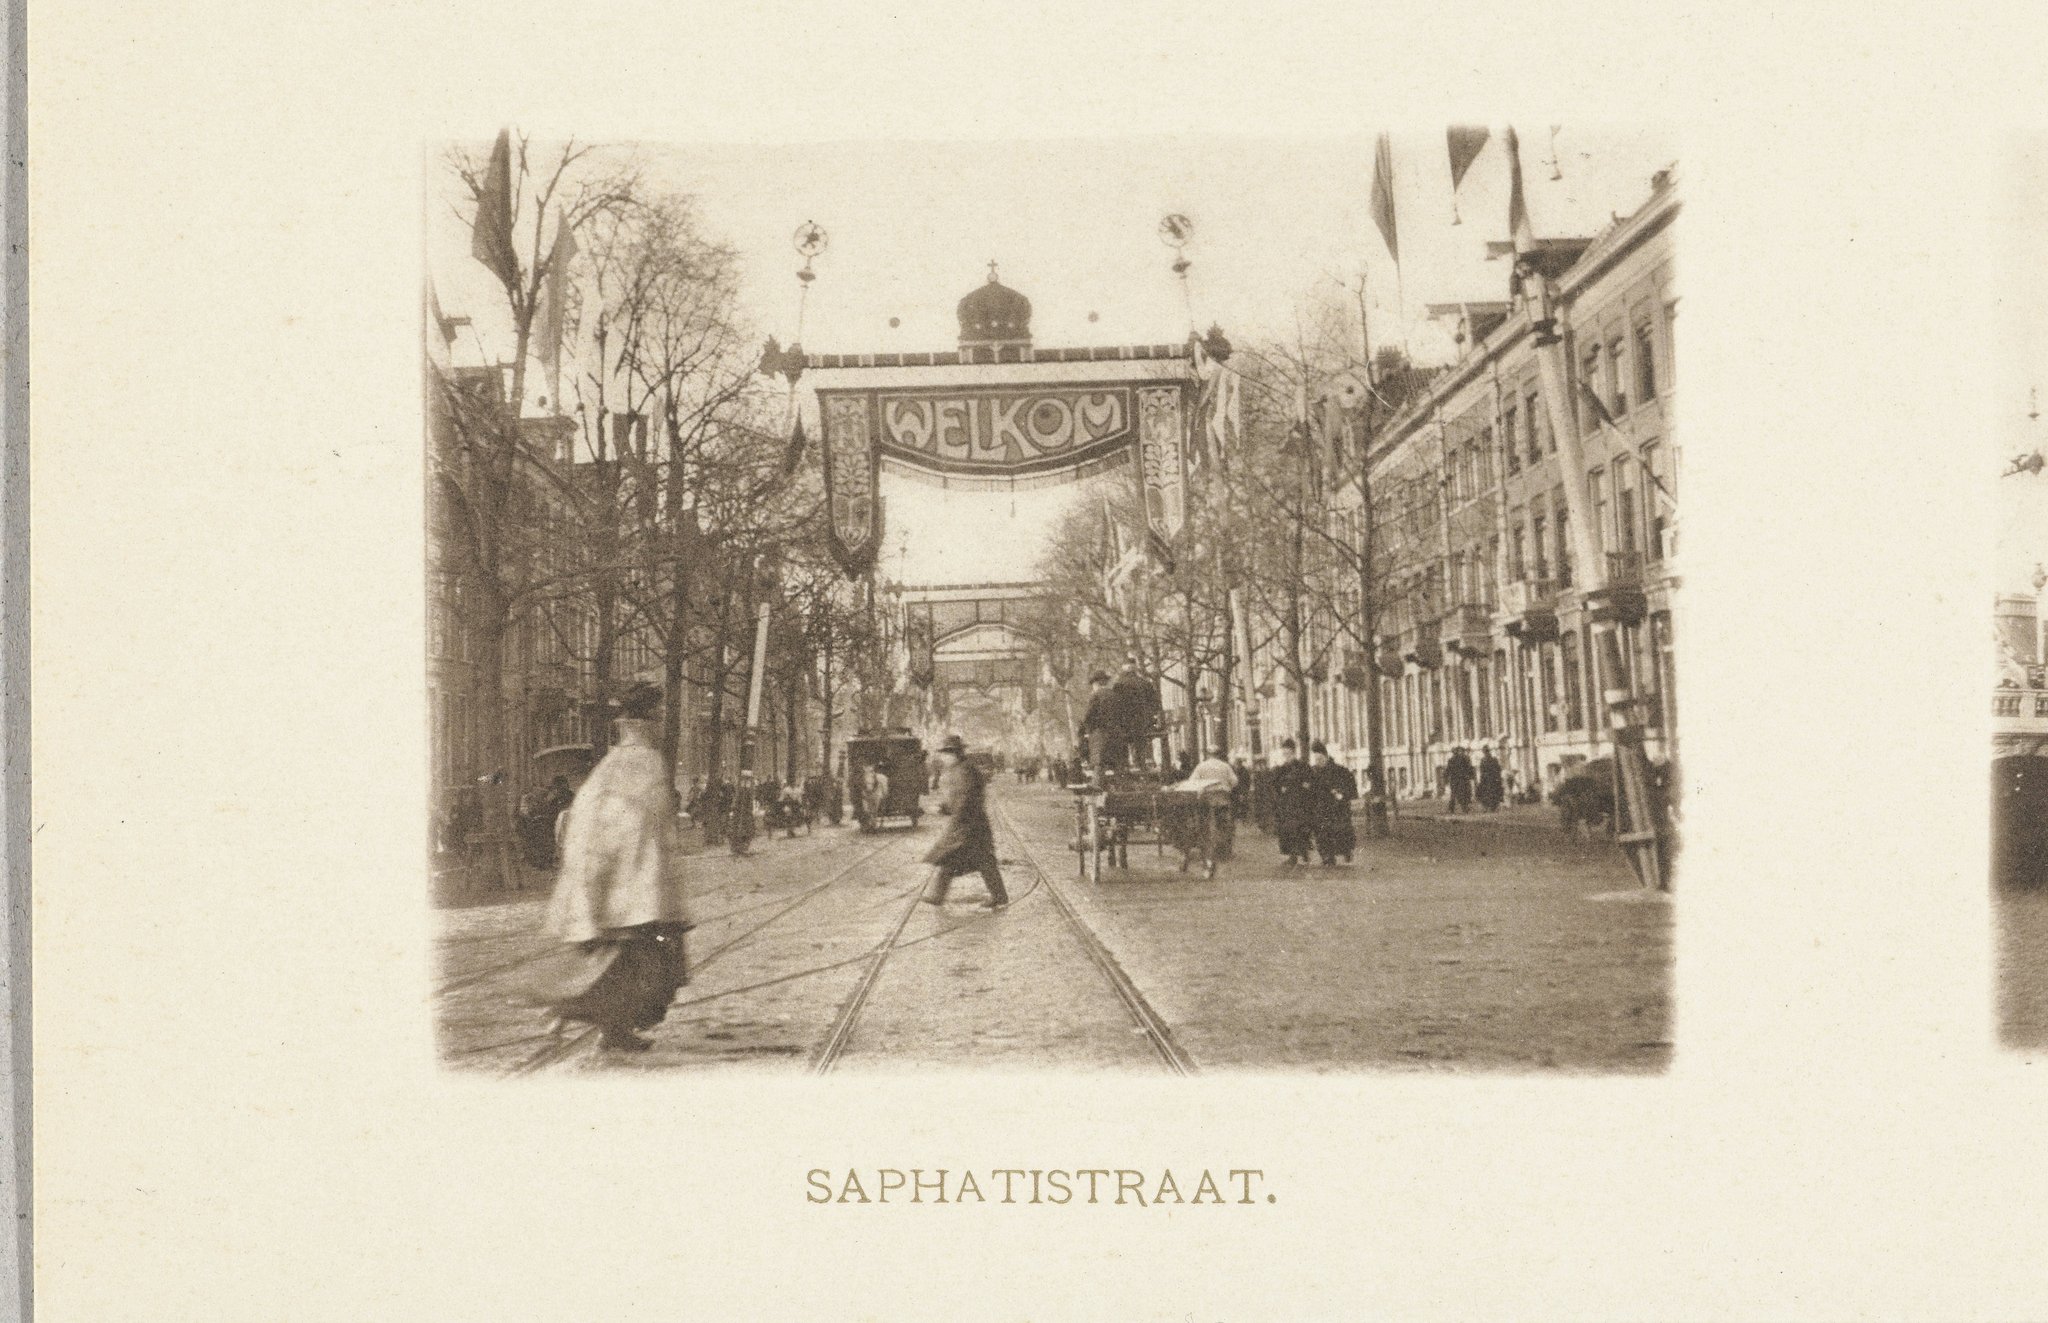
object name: photograph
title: Saphatistraat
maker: barend groote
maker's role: fotograaf, fotohandel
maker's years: 1862-1946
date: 1901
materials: paper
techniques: photograph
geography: amsterdam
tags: the hague, print maker, wilhelmina of the netherlands, decorations, honours (as symbols of the state, etc.), historical events and situations, amsterdam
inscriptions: annotation: ‘Saphatistraat’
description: Amsterdam, 5 februari 1901, feestelijkheden t.g.v. het huwelijk van koningin Wilhelmina en prins Hendrik: